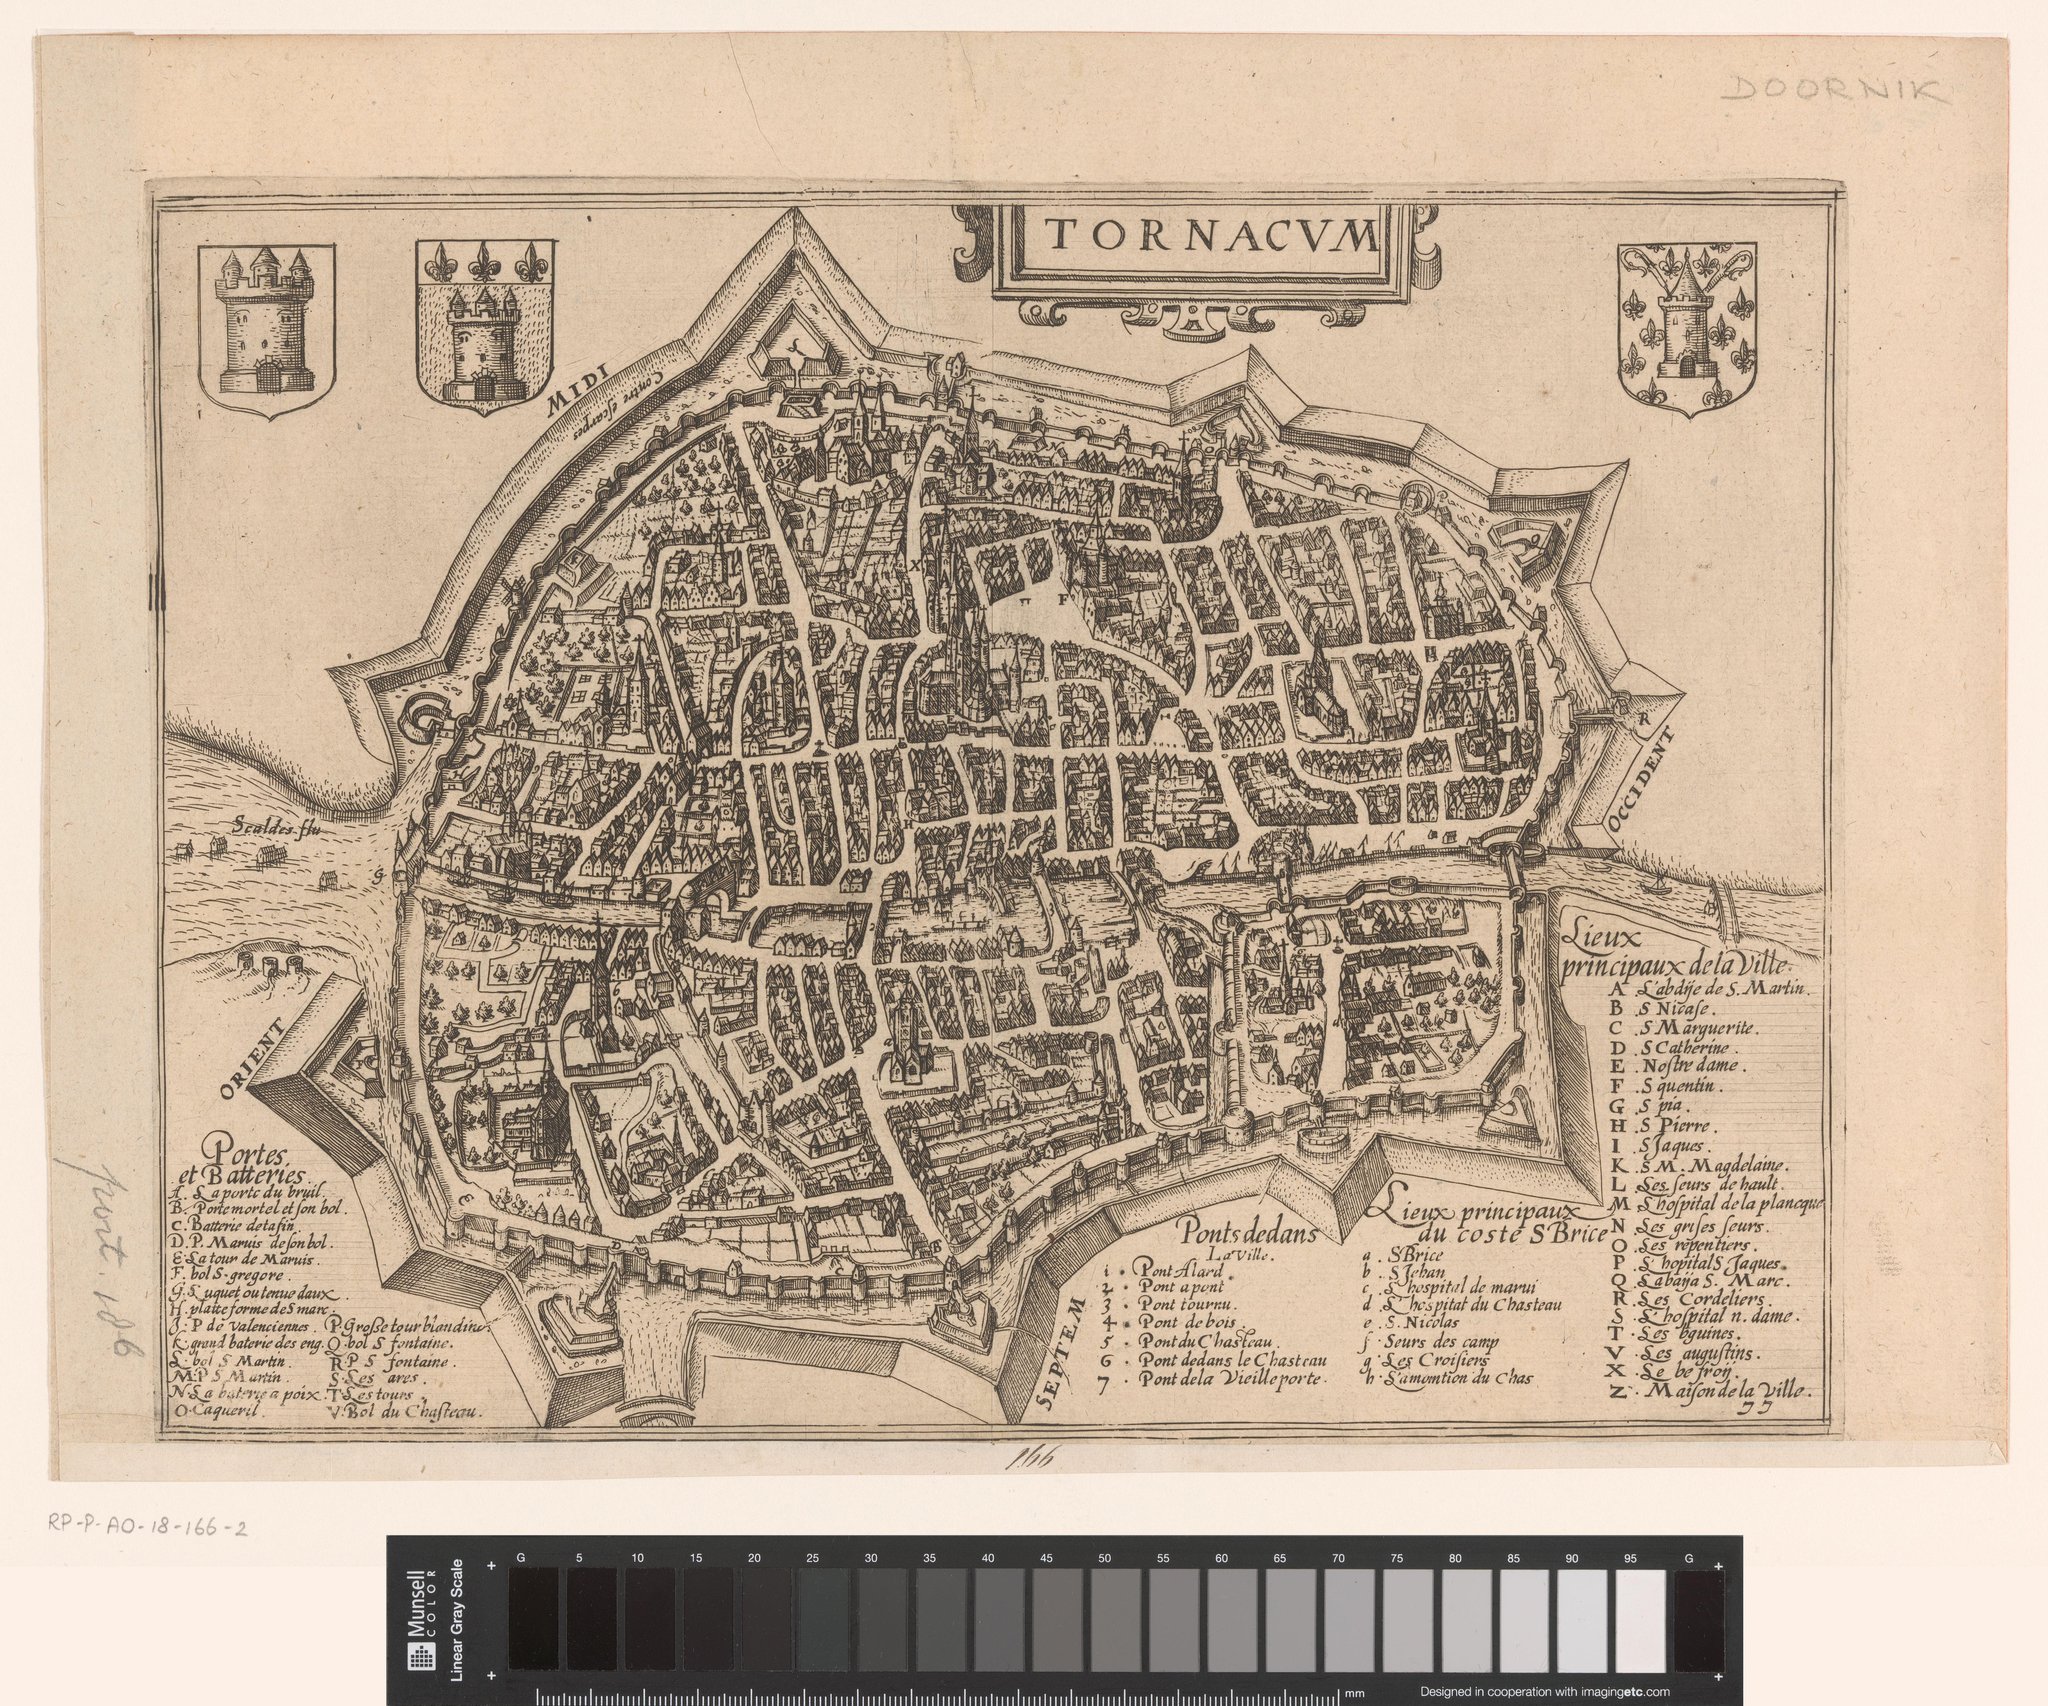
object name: area plan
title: Tornacum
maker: Anonymous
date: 1612-1648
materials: paper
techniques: engraving, etching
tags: coat of arms (as symbol of the state, etc.) (+ city; municipal), maps of cities, coat of arms (as symbol of the state, etc.) (+ province; provincial)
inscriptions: collector's mark: Lugt 2228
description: Deze staat van prent voor het eerst ook gebruikt in: Guicciardini, Lodovico. Beschryvinghe van alle de Neder-landen, anderssins ghenoemt Neder-Duytslandt (…). Amsterdam: Willem Janszoon Blaeu, 1612. Hierna is deze prent tot 1648 nog gebruikt in latere uitgaven van deze publicatie, uitgegeven door Blaeu en daarna door Janssonius. Uit welke uitgave het huidige exemplaar precies komt is niet na te gaan.